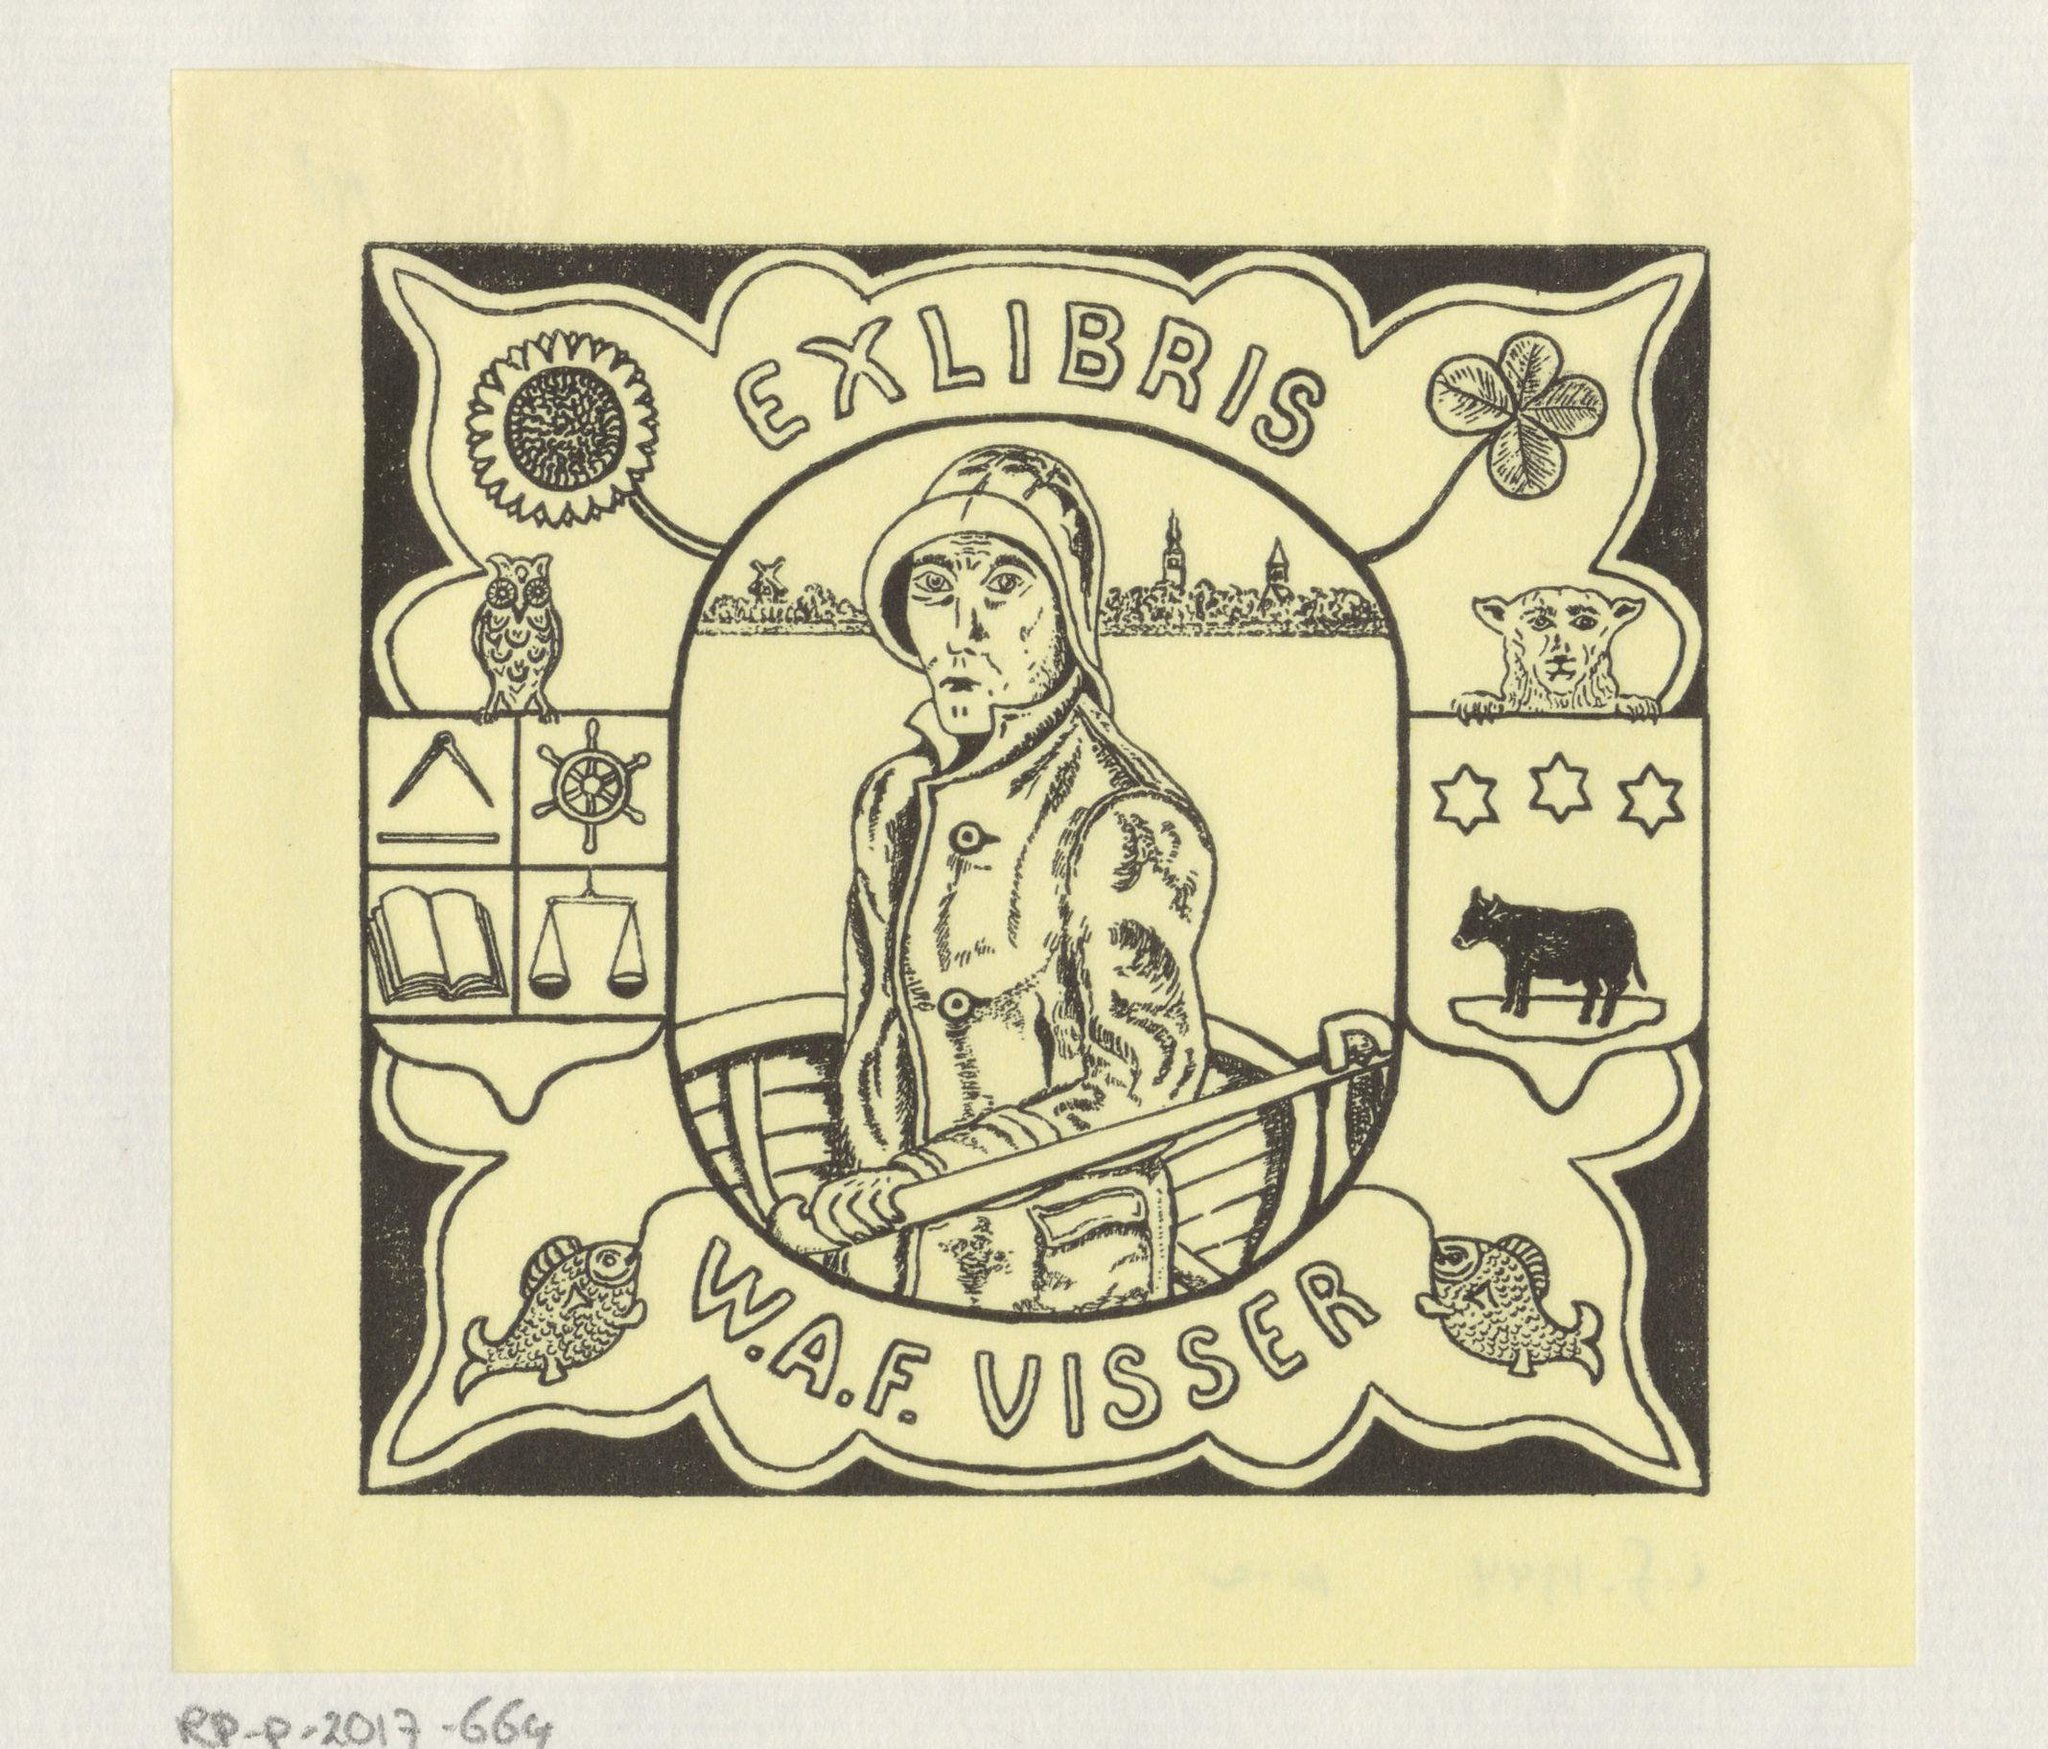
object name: bookplate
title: Ex libris van W.A.F. Visser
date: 1944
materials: paper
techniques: printing block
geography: netherlands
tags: w.a.f. visser, fishes, book, fisherman, armorial bearing, heraldry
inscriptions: signature and date: ‘i.f. 1944’